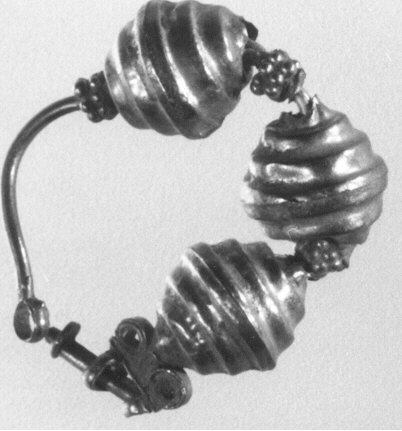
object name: earring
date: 1001-1300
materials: gold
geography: iran